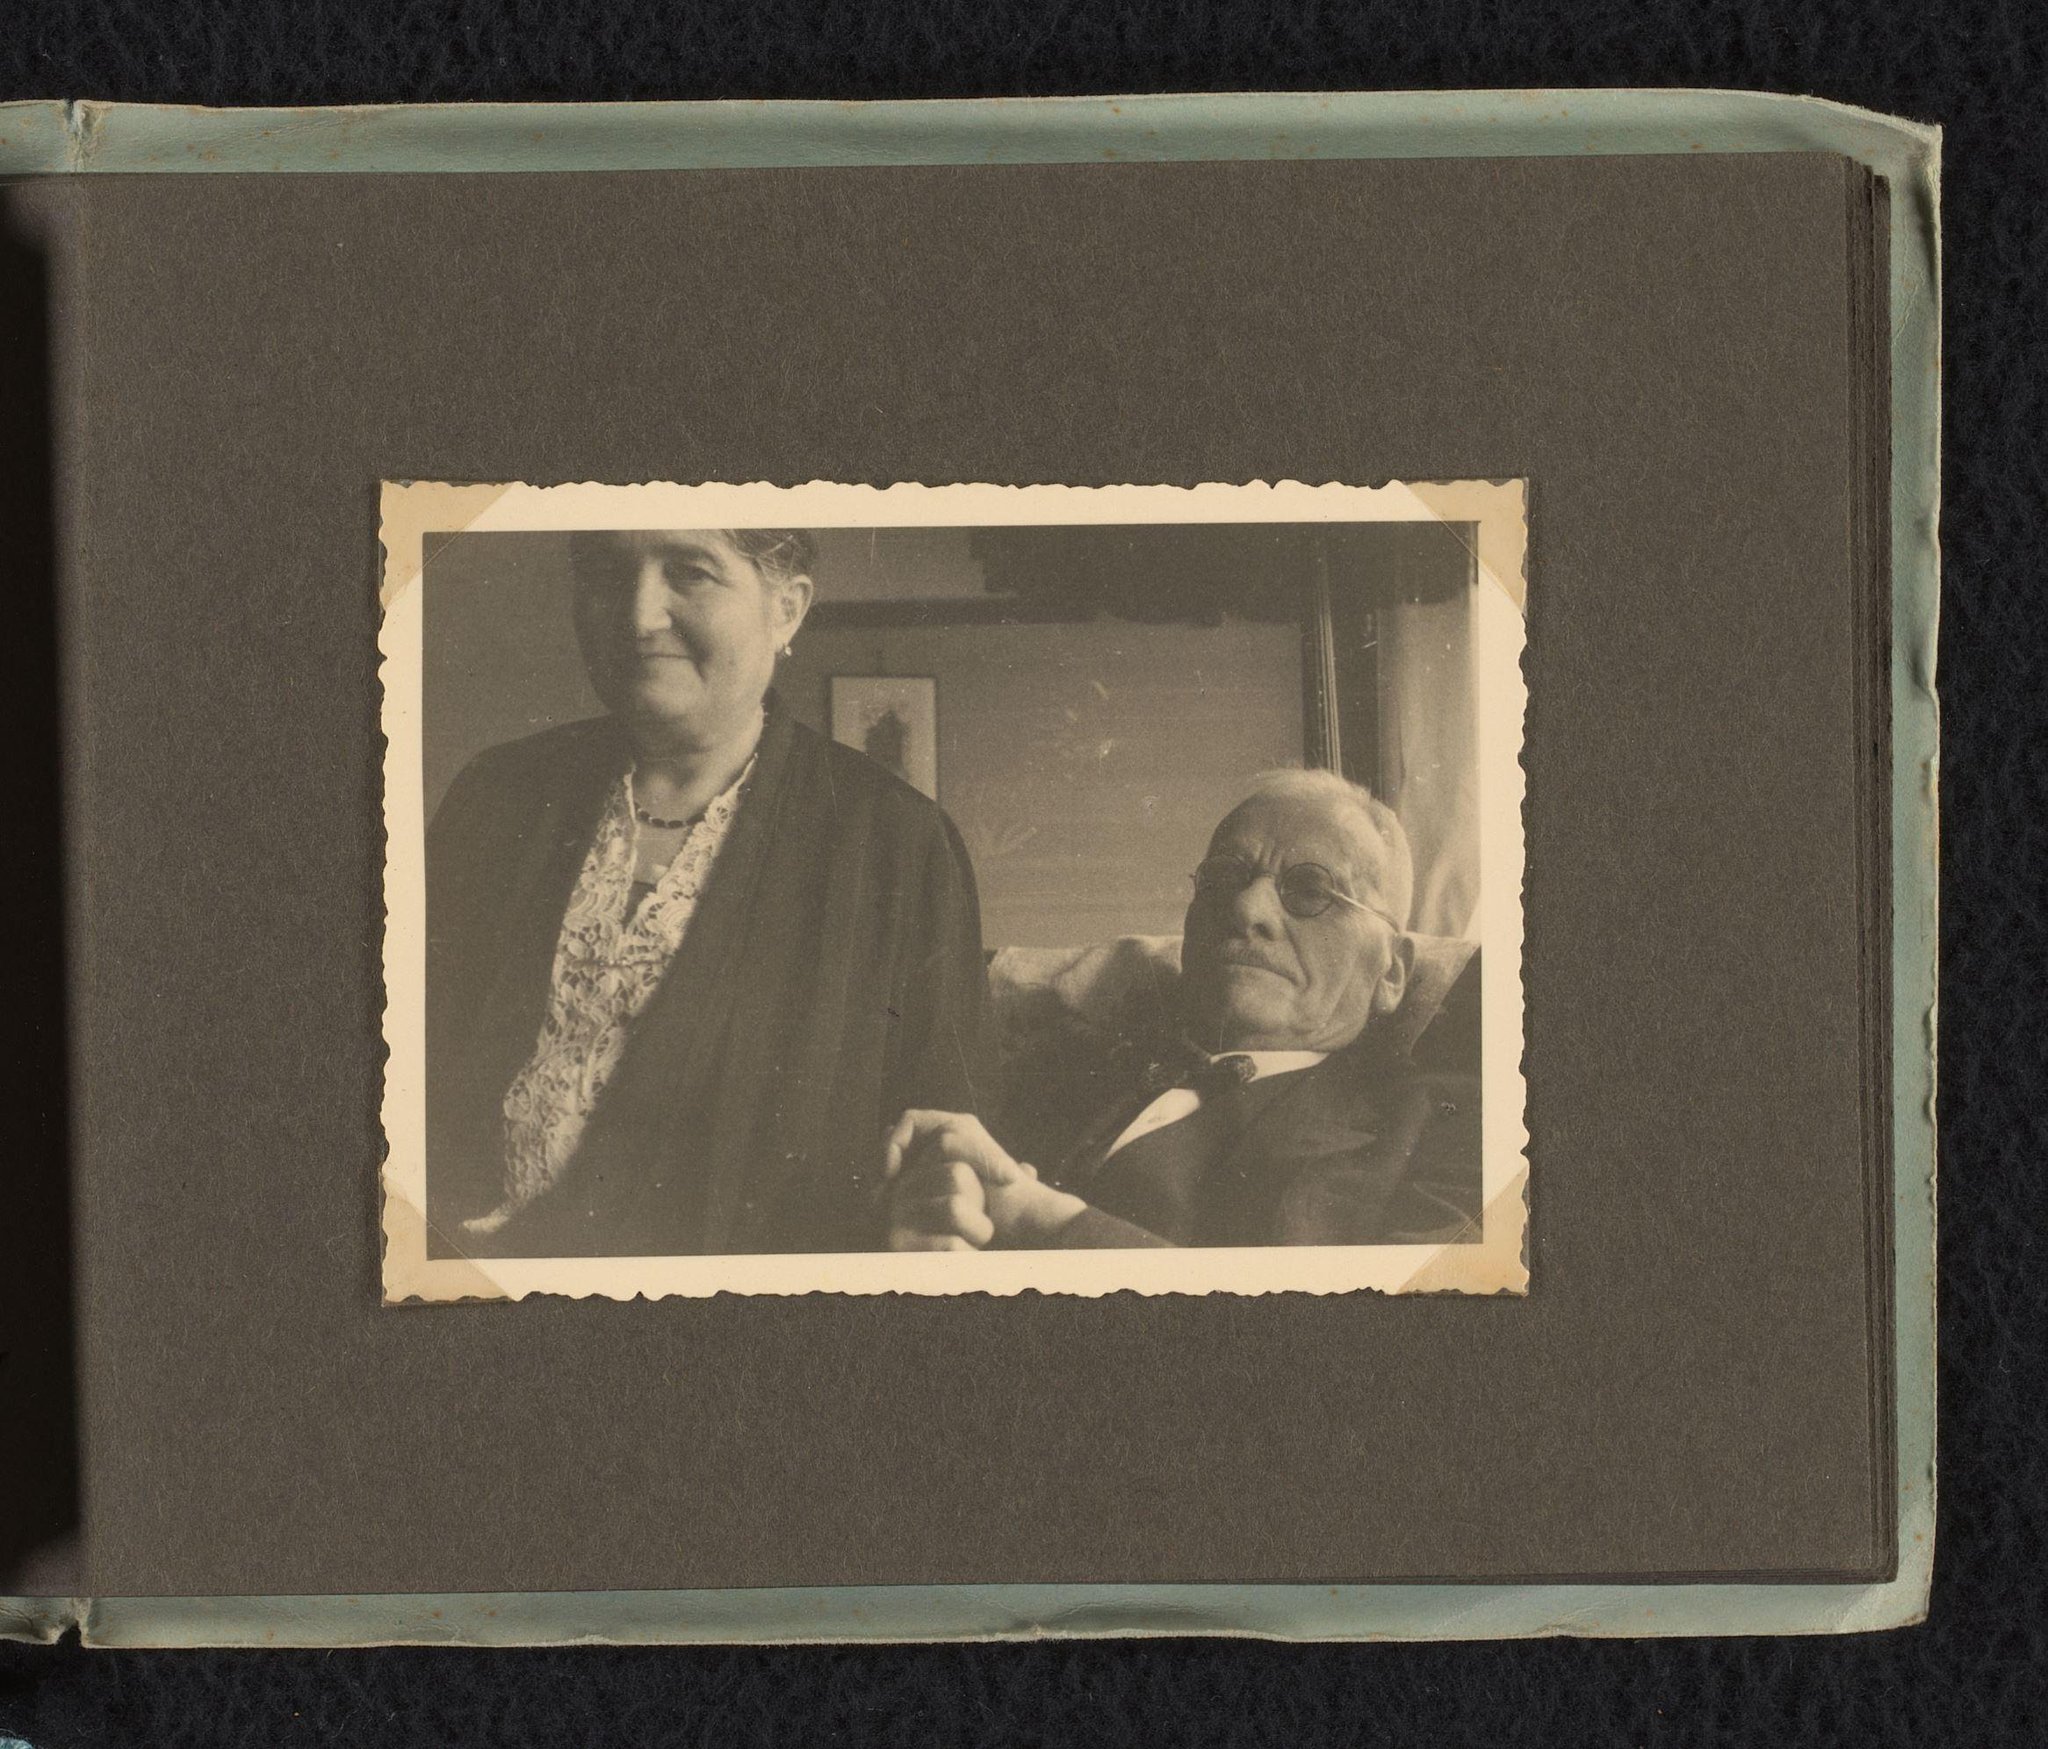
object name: album leaf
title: Isabel's grootouders Meir Wachenheimer en zijn echtgenote Mathilde Wachenheimer-Wertheimer in de woning van de familie Wachenheimer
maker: else wachenheimer-moos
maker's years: 1895-1944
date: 1932-1937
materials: cardboard, photographic support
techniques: gelatin silver print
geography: stuttgart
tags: historical persons - bb - woman, historical persons, family life at home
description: Blad bevat één foto van Meir Wachenheimer en Mathilde Wachenheimer-Wertheimer. Onderdeel van het fotoalbum 1932-1937, Stuttgart.